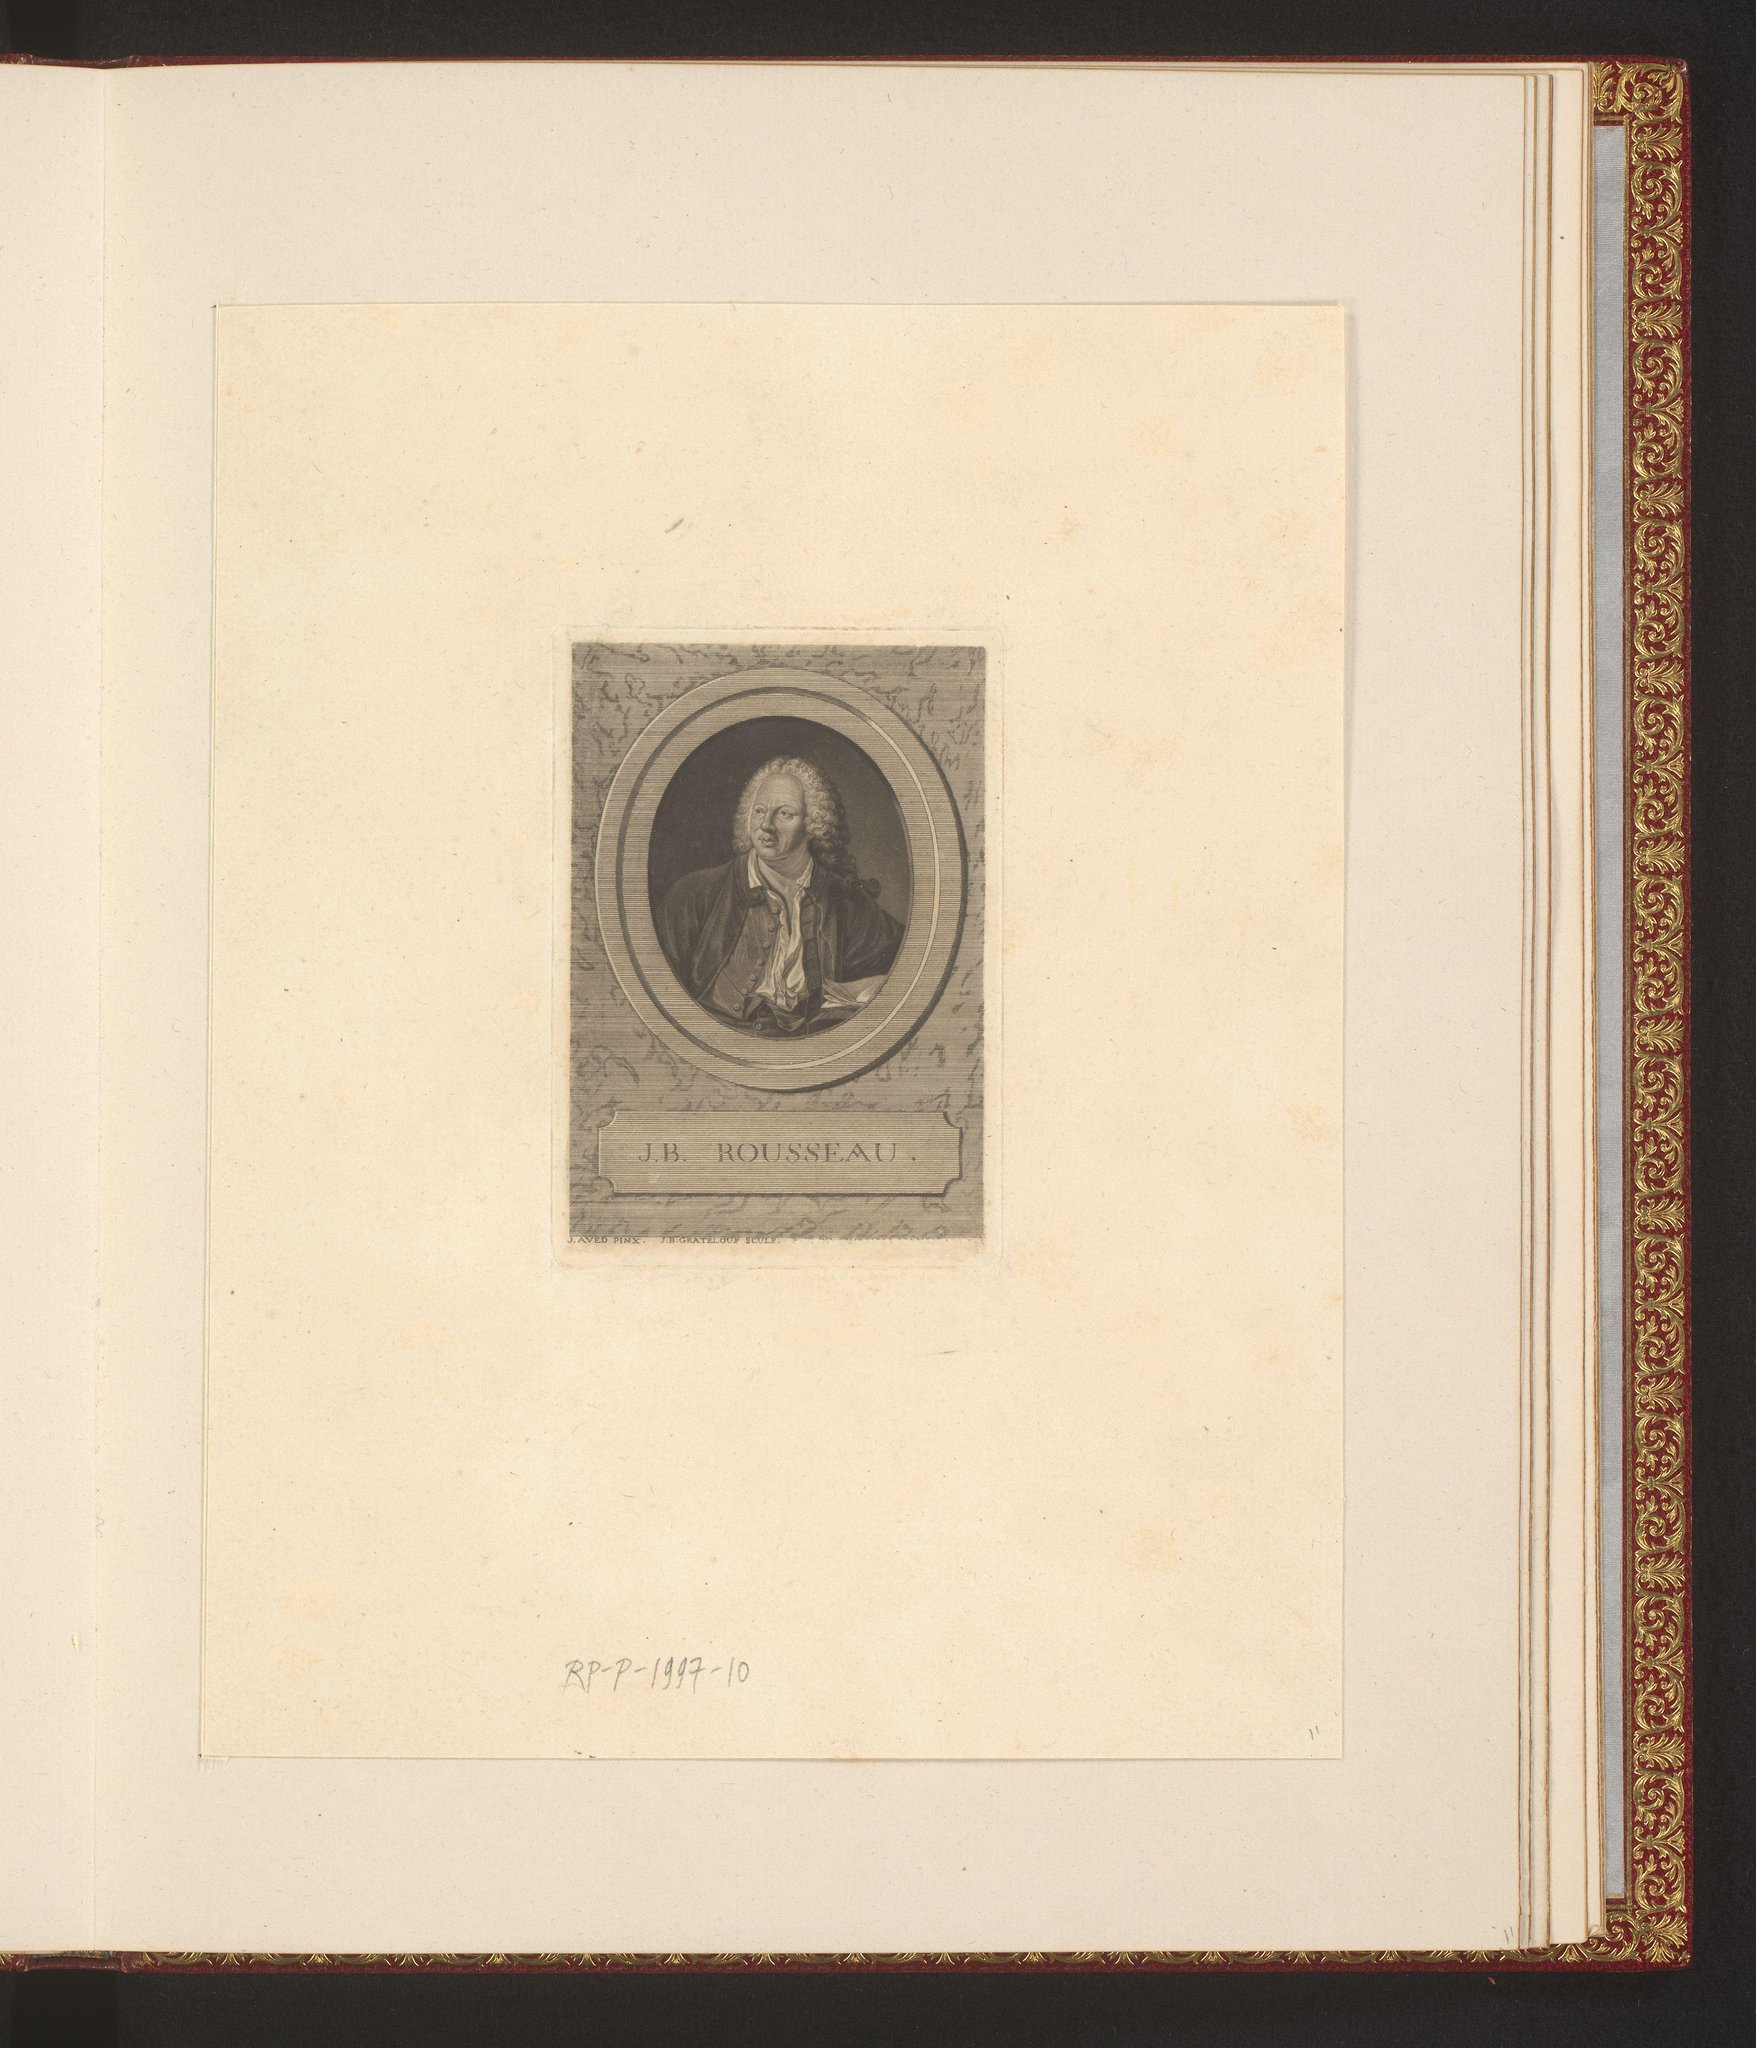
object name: album leaf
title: J.B. Rousseau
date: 1766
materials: paper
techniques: aquatint, etching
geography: france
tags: historical persons, aspects of science in general (+ portrait of scholar, scientist)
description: Deze prent maakt deel uit van een album.